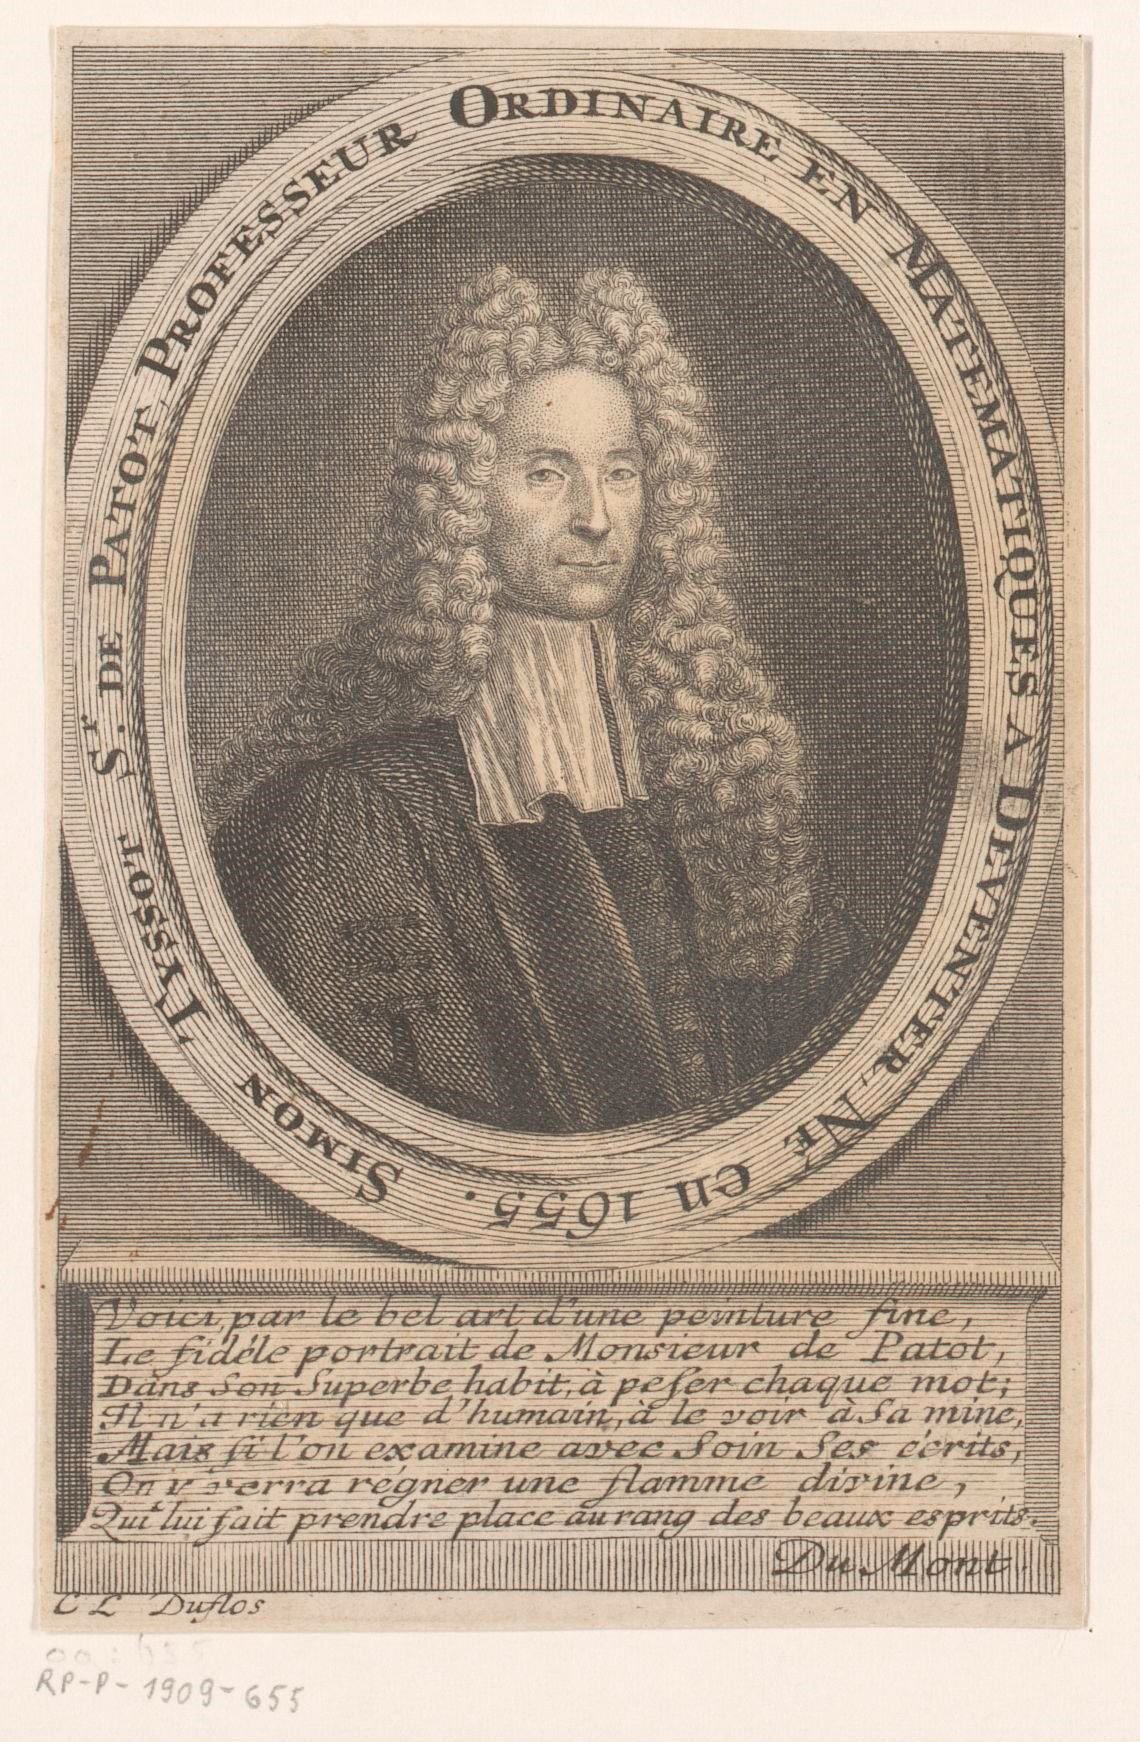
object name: print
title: Portret van Simon Tyssot de Patot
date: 1695-1727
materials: paper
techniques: engraving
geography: france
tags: london, ornament ~ medallion, portrait of a writer, writer, poet, author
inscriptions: collector's mark: Lugt 2228